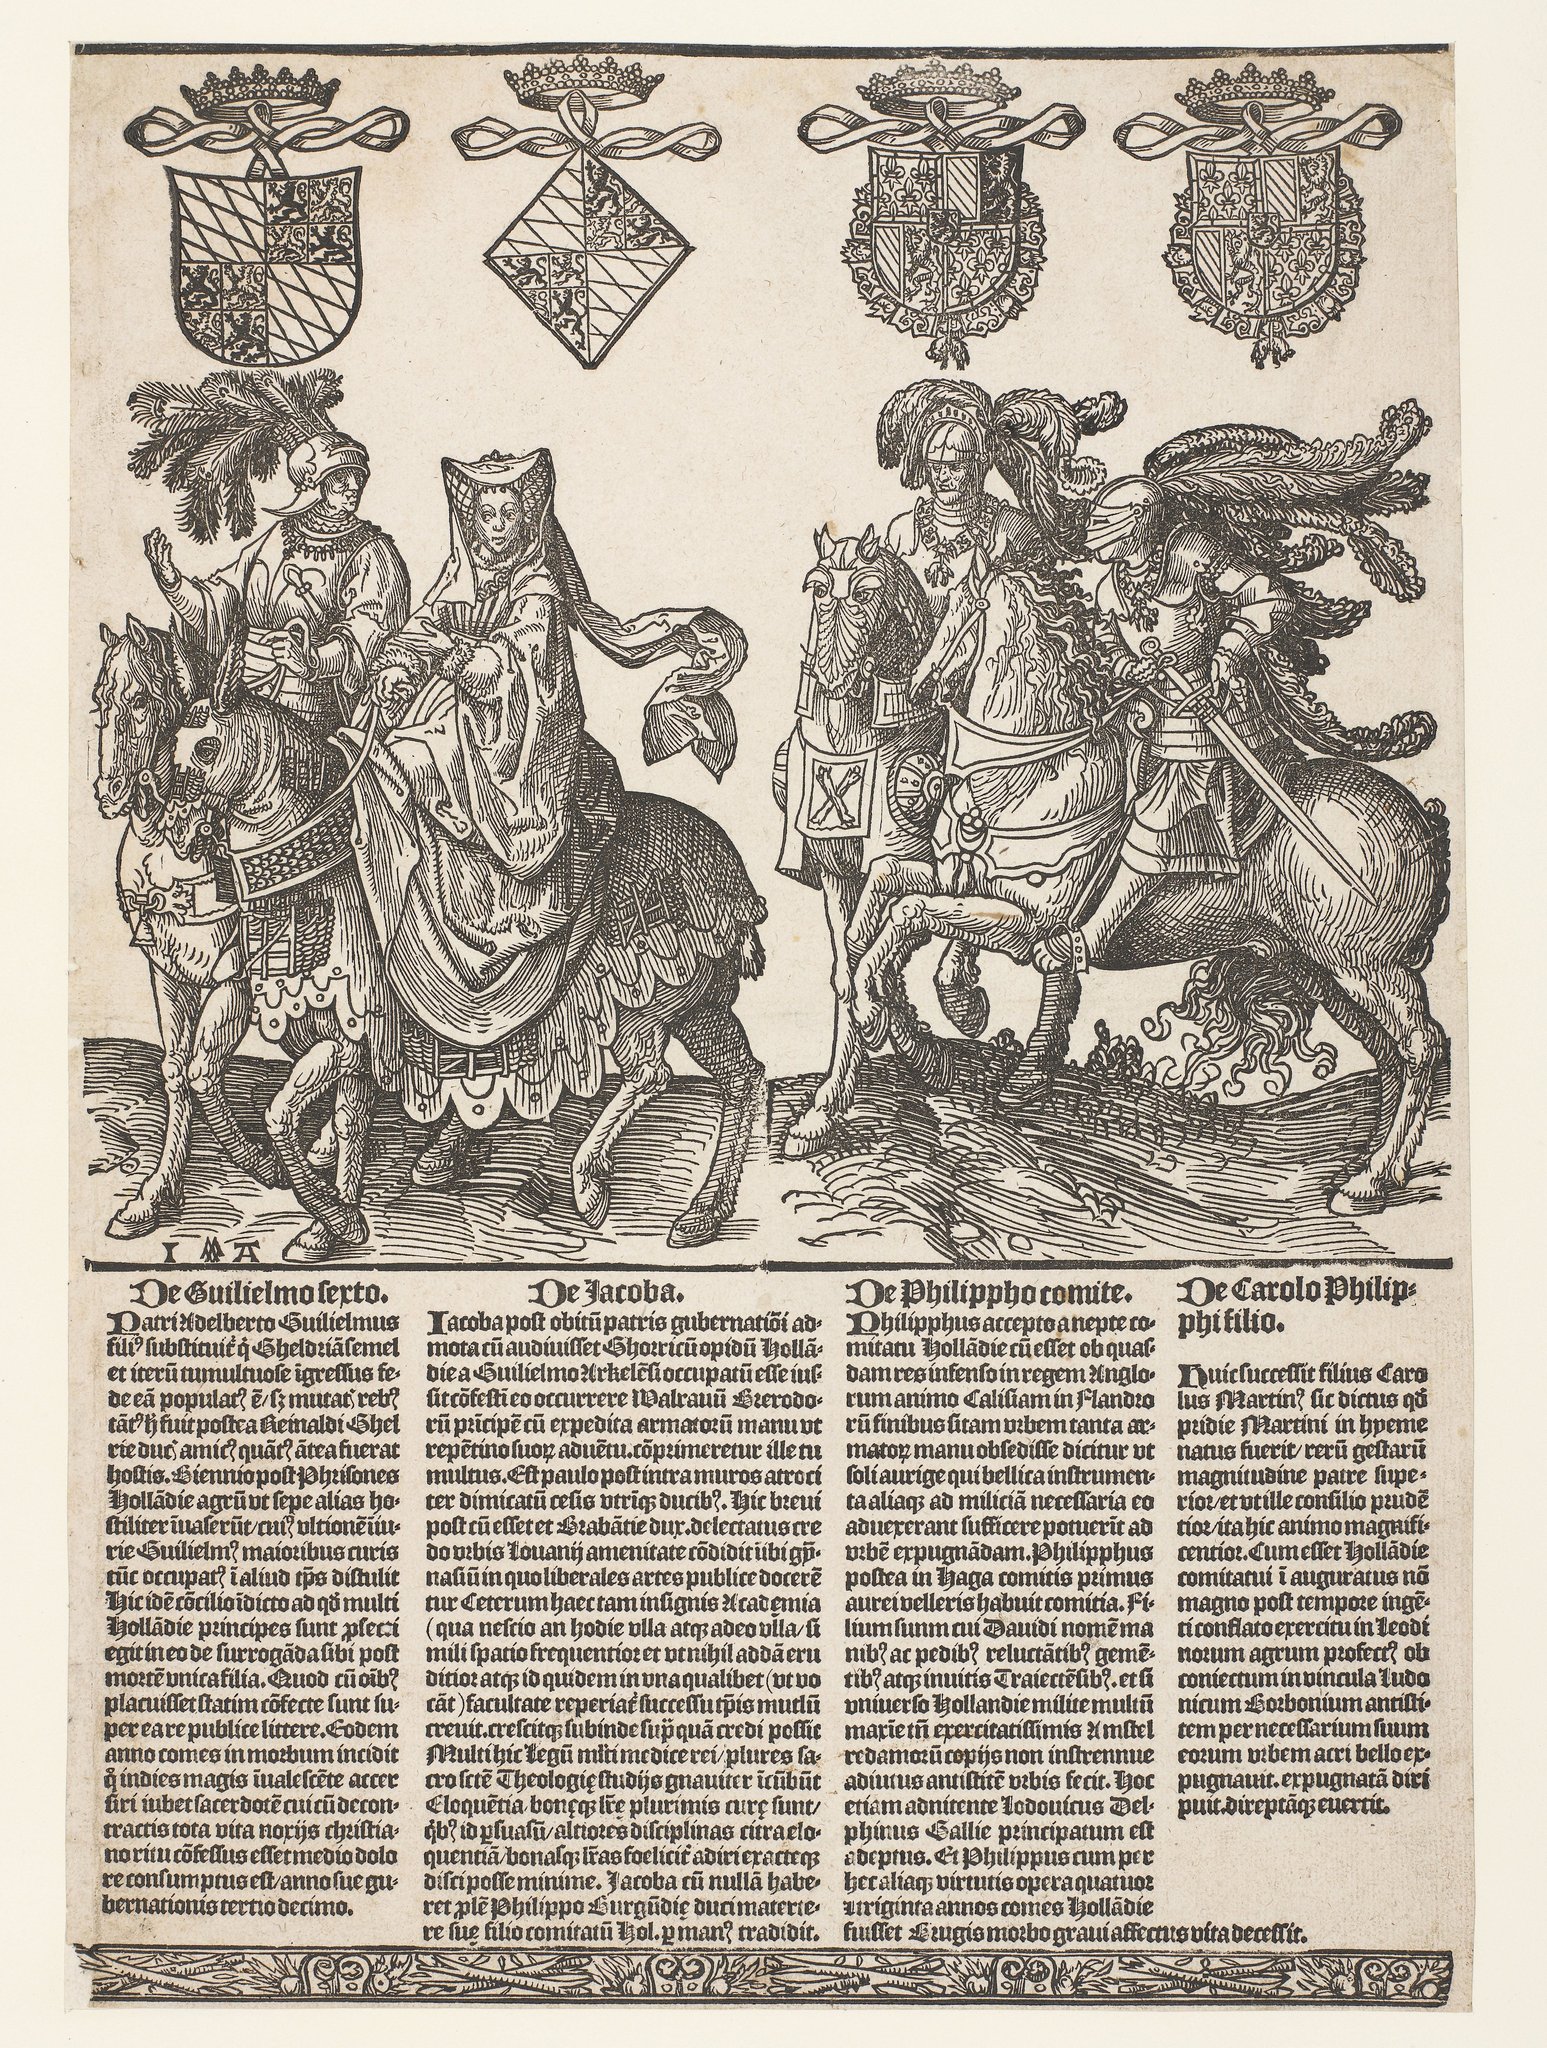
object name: print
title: De Graven en Gravinnen van Holland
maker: jacob cornelisz van oostsanen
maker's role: draughtsman, painter, print maker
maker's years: 1475-1533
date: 1518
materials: paper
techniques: woodcut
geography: low countries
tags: bruges, philip iii the good, jacoba of bavaria (countess of hainaut), holland en zeeland willem vi van henegouwen, earl, charles the bold (duke of burgundy)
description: Blad uit serie van negen bladen, gedrukt van twee blokken. Willem de VI, Philips de Goede, Karel de Stoute, graven van Holland en Zeeland en Jacoba van Beyeren, gravin van Holland en Zeeland, te paard gezeten. Boven de afbeeldingen van de personen hun met met kronen gedekte wapenschilden. Onder de prent in boekdruk in vier kolommen een kort levensbericht in het Latijn van de bovengenoemde vorsten en vorstin